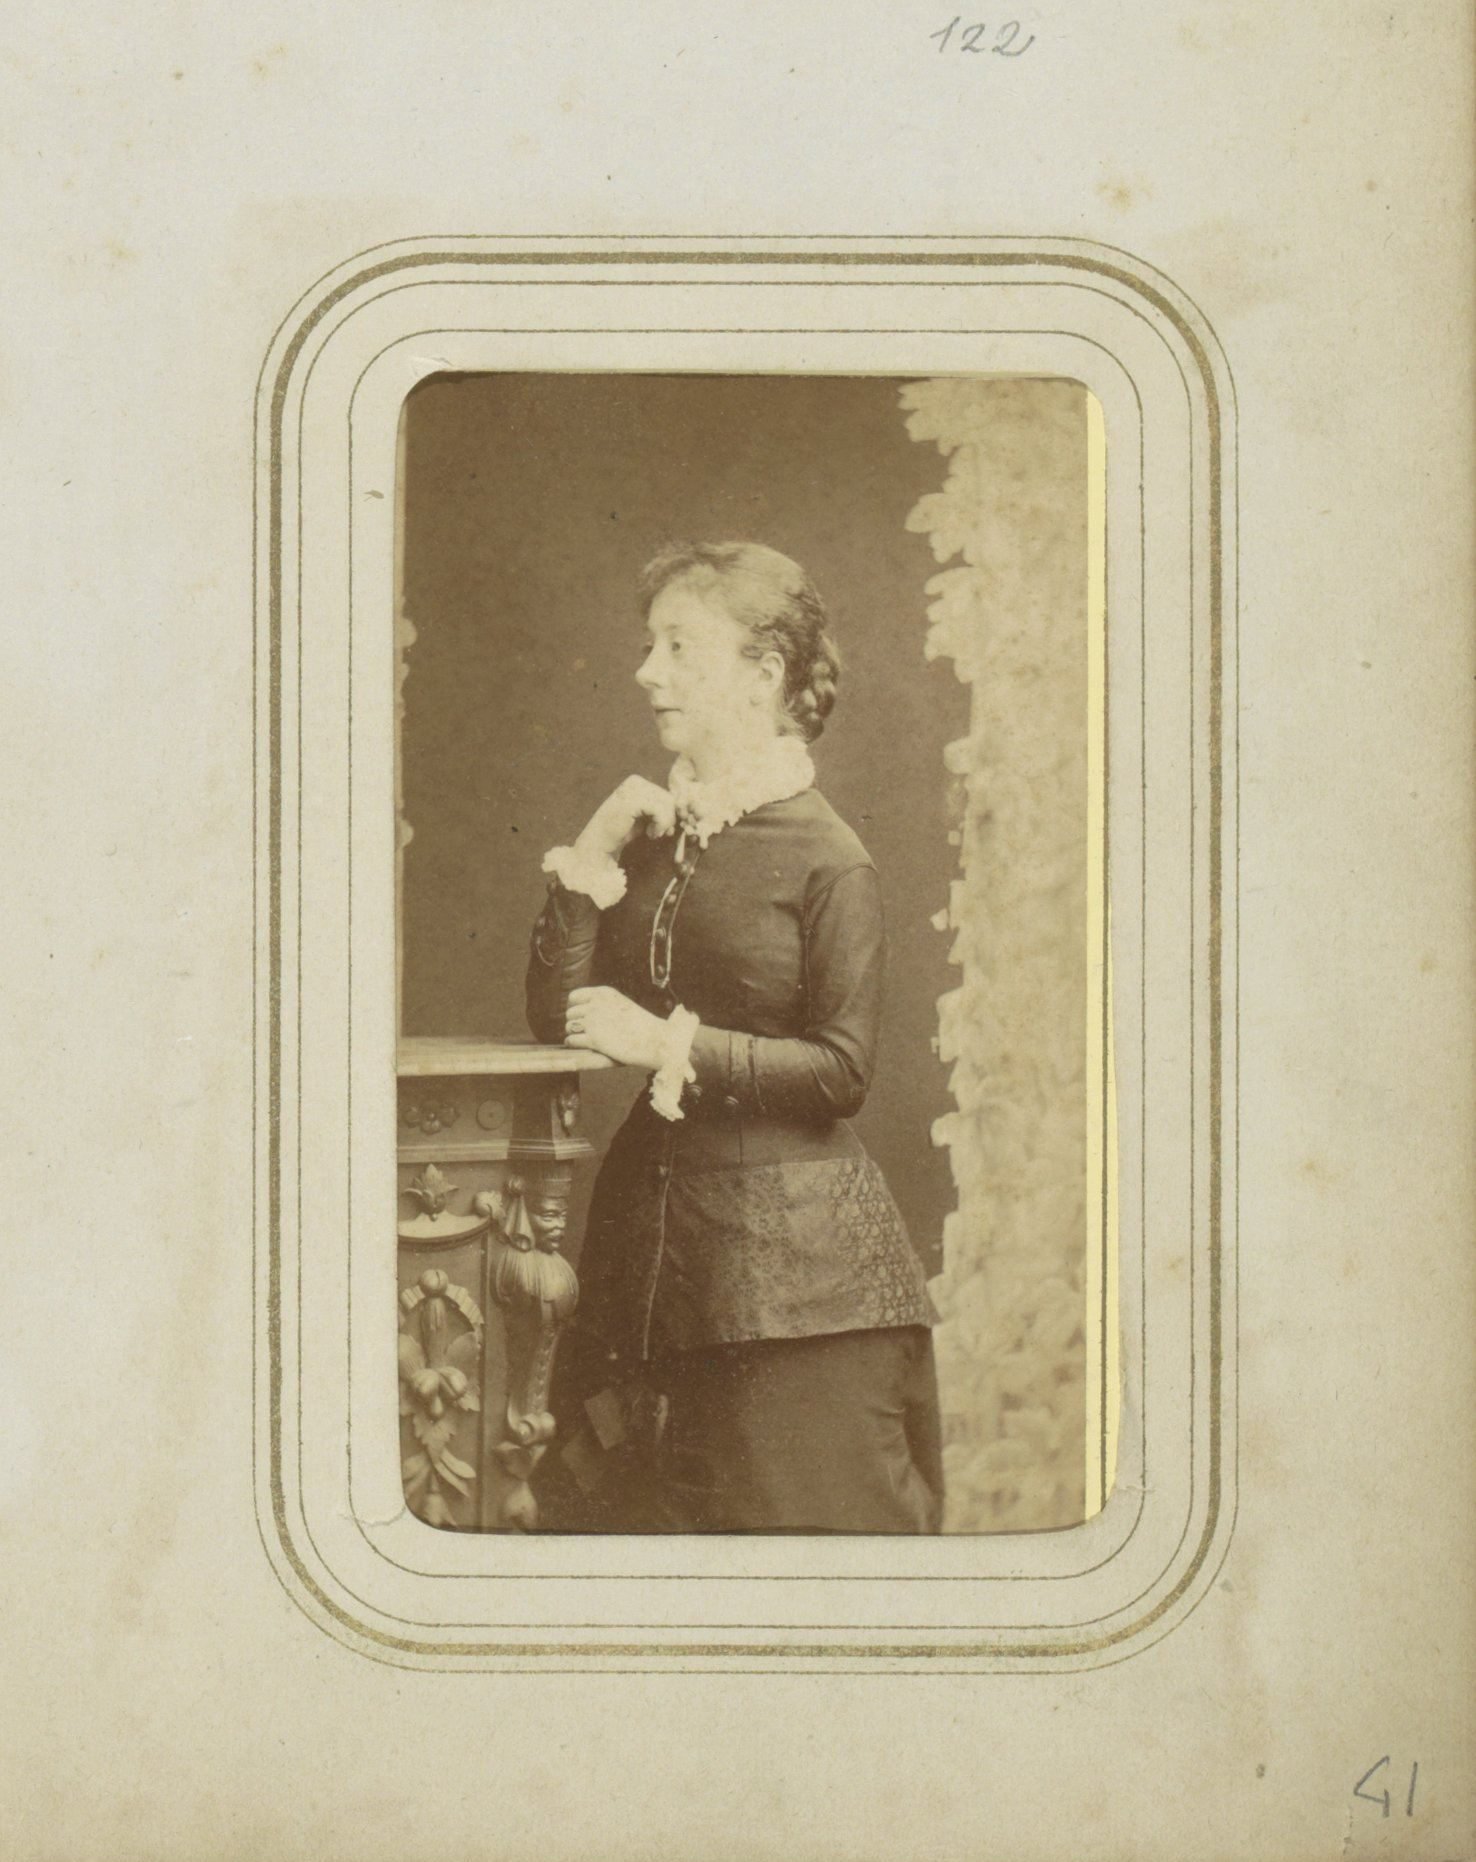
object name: carte de visite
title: Portret van een vrouw in een jasje en een rok, aangeduid als Ans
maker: heinrich wilhelm wollrabe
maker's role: fotograaf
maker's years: 1843-1928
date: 1877-1895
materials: cardboard, photographic support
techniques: albumen print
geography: the hague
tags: historical persons, neck-gear ~ clothing, clothing for the upper part of the body, skirt, family, relationship, descent, dress, gown, the hague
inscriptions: address: ‘96. Noordeinde 96. 's Gravehage’, inscription: ‘Ans [...]’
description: Onderdeel van Familiealbum van H.W.F. Ligtenberg en L.M. Swart met 149 foto's en cartes-de-visite.